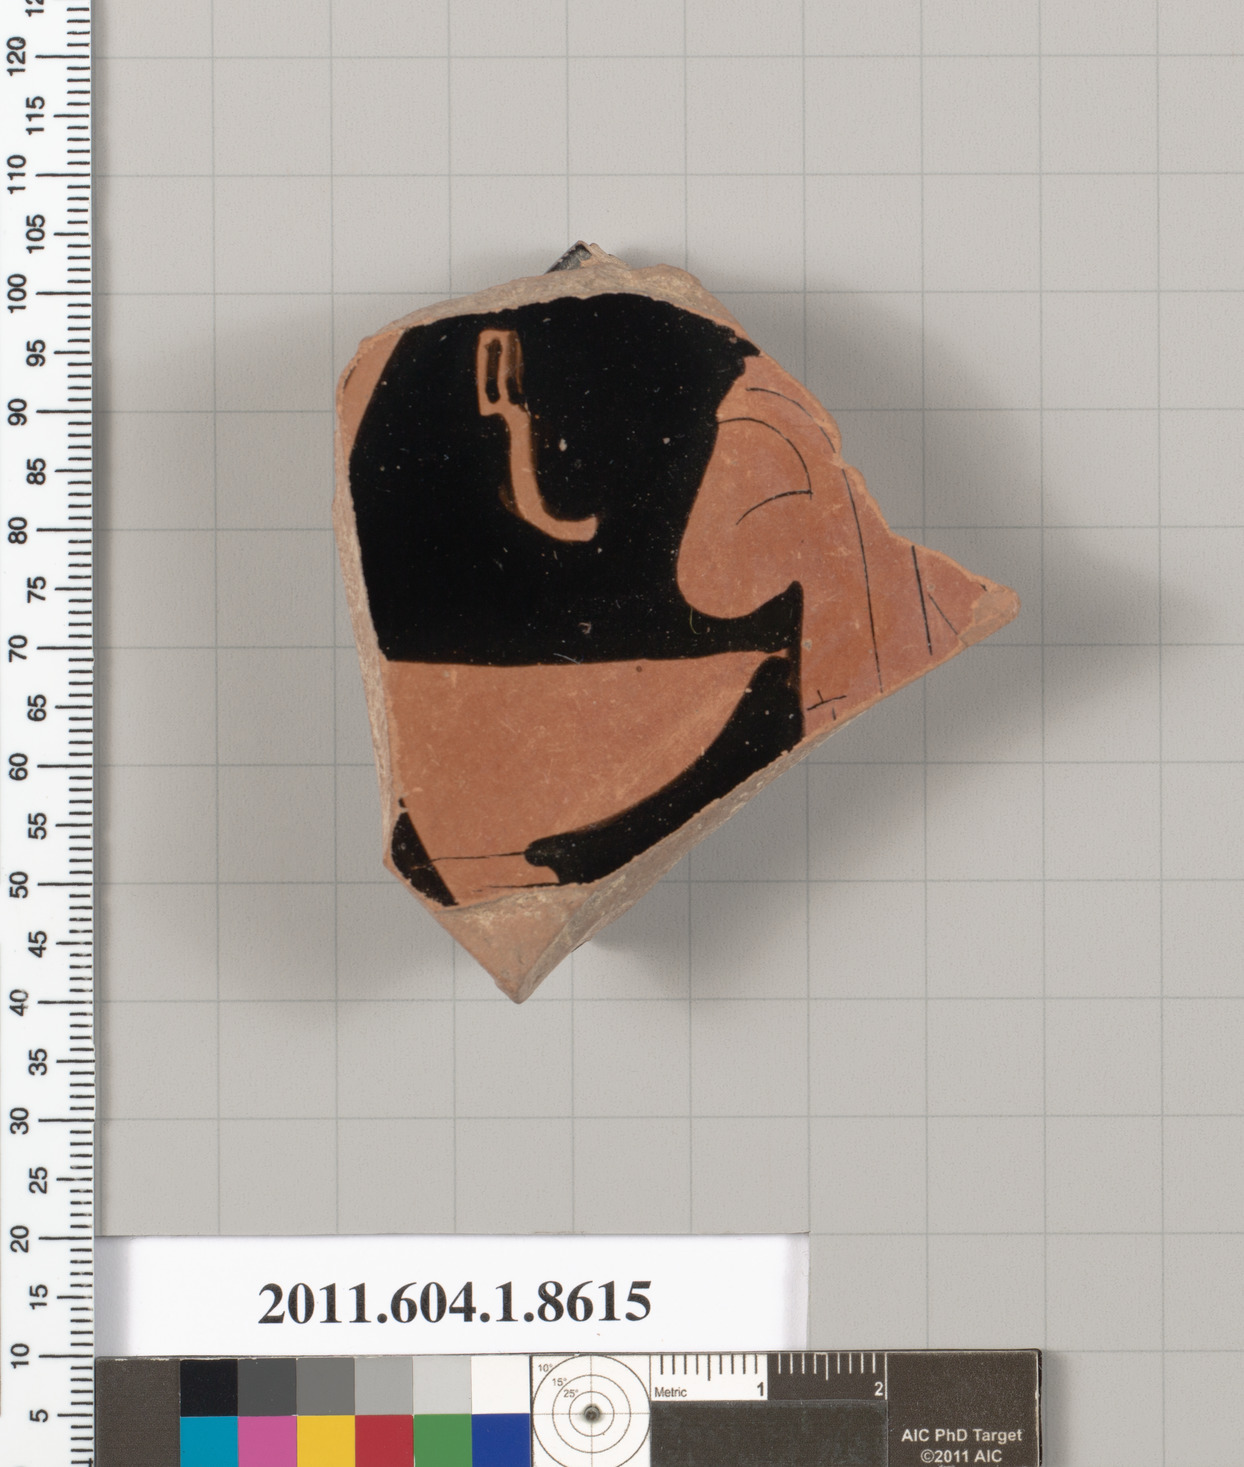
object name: kylix fragment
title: Terracotta fragment of a stemless kylix (drinking cup)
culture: greek, attic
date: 460-450 BCE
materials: terracotta